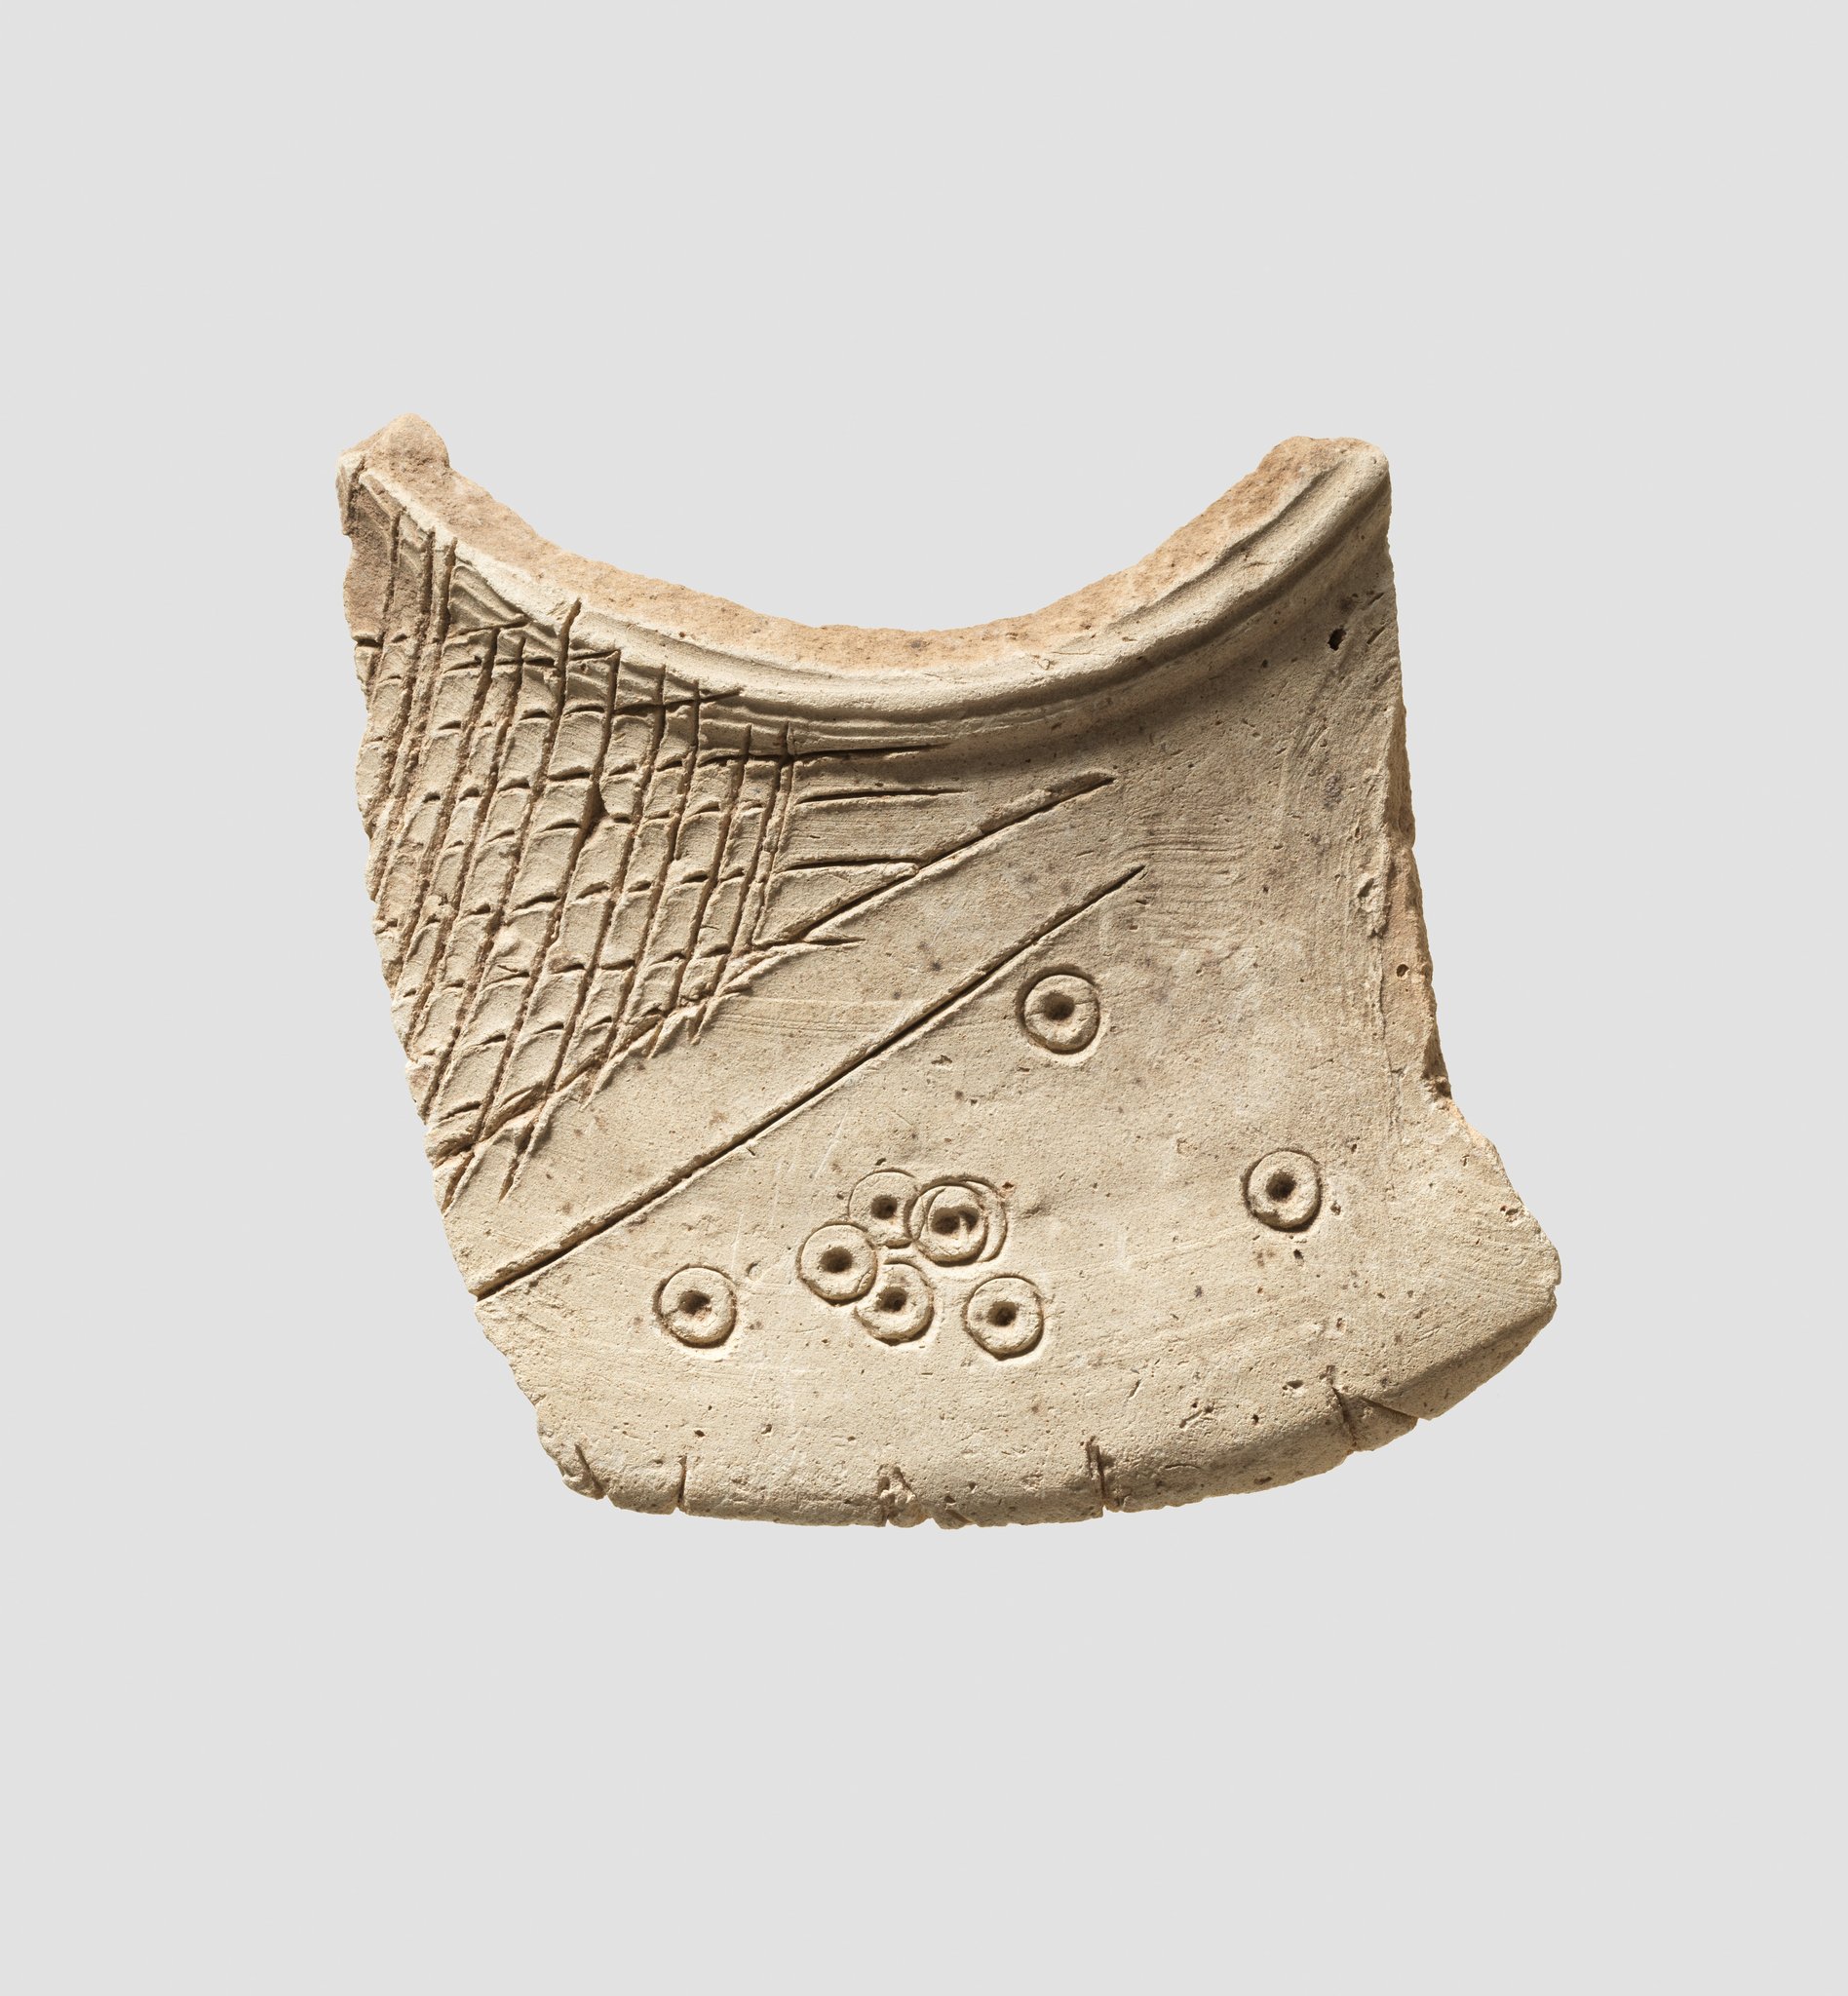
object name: sherd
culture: sasanian or islamic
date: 501-800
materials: ceramic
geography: mesopotamia